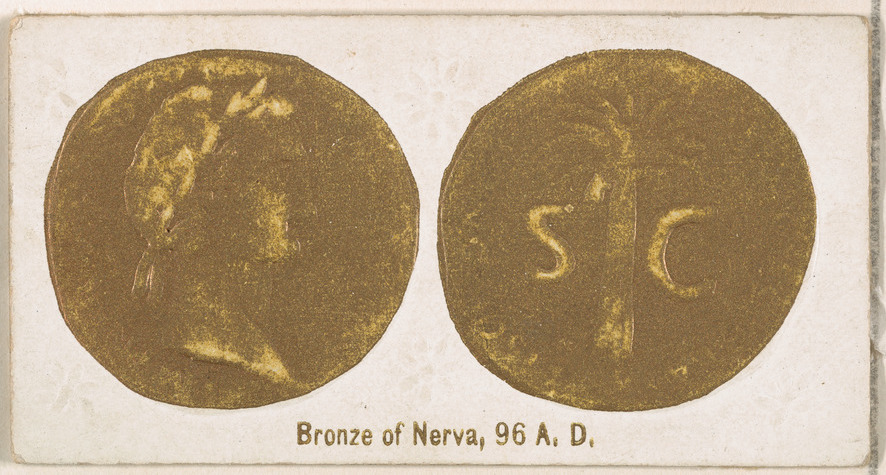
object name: print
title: Bronze of Nerva, 96 A.D., from the Ancient Coins series (N180) issued by Wm. S. Kimball & Co.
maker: william s. kimball & company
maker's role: publisher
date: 1888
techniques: color lithograph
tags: coins